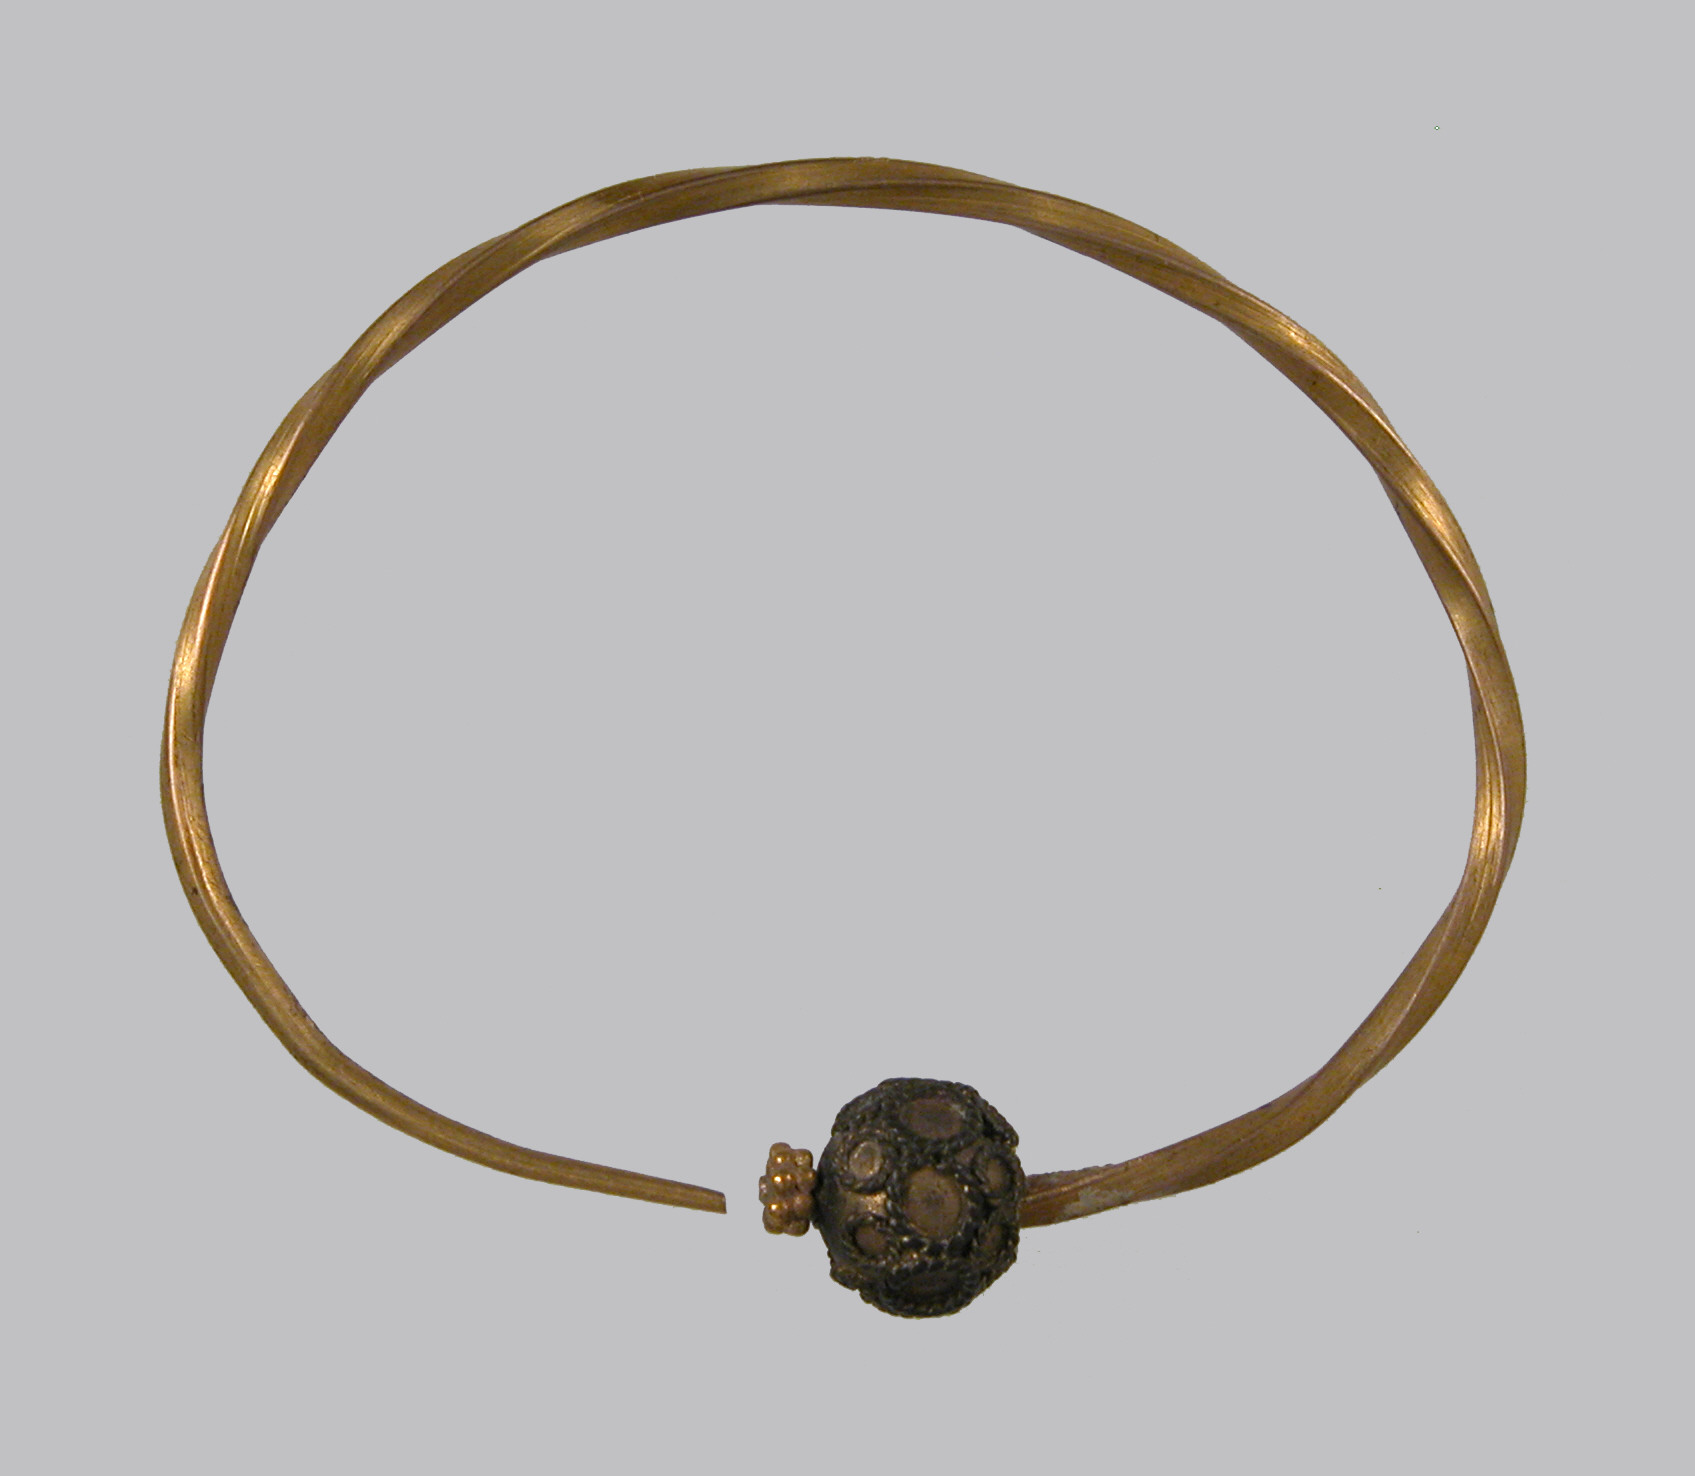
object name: earring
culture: frankish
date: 501-700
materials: gold, metal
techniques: filigree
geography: northern france